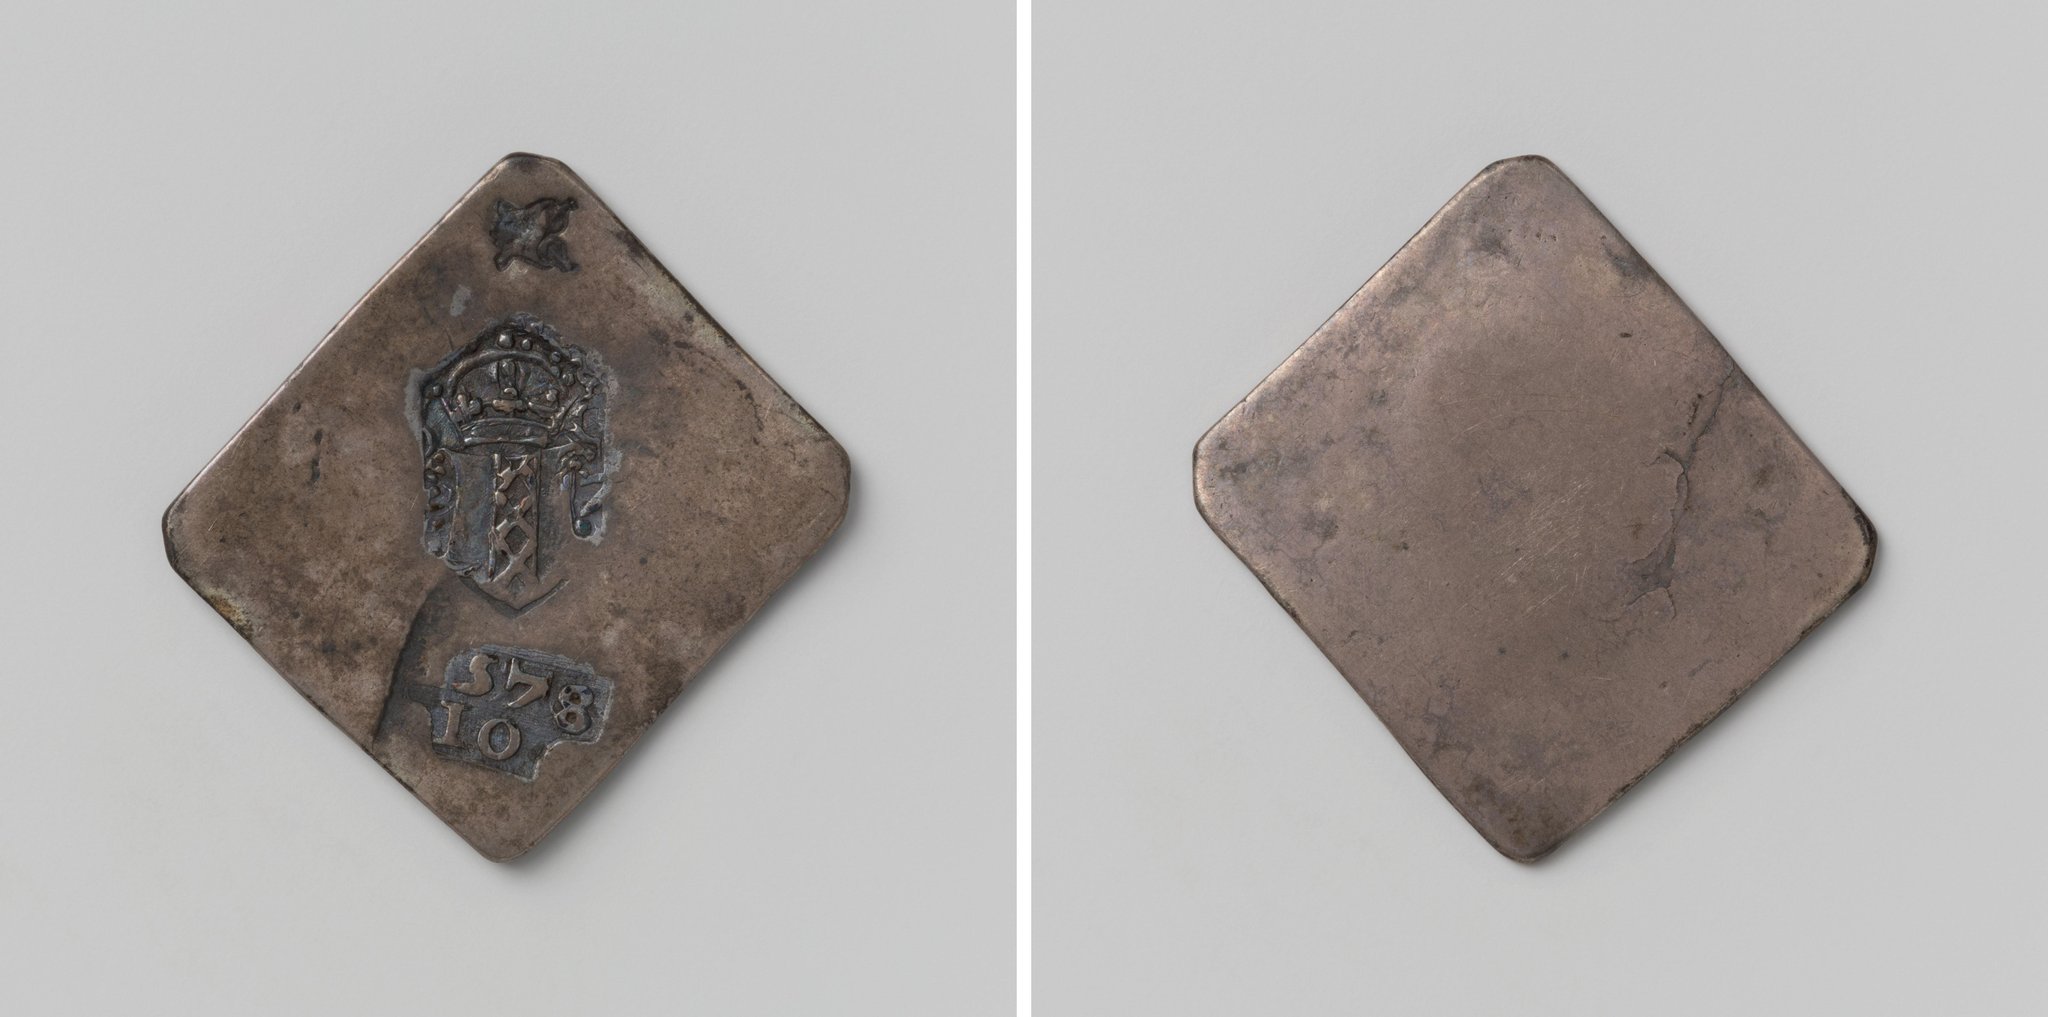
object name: tien stuiver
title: Tien stuiver, noodmunt uit Amsterdam, geslagen na het beleg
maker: Anonymous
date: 1578-1631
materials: silver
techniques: striking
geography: amsterdam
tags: amsterdam